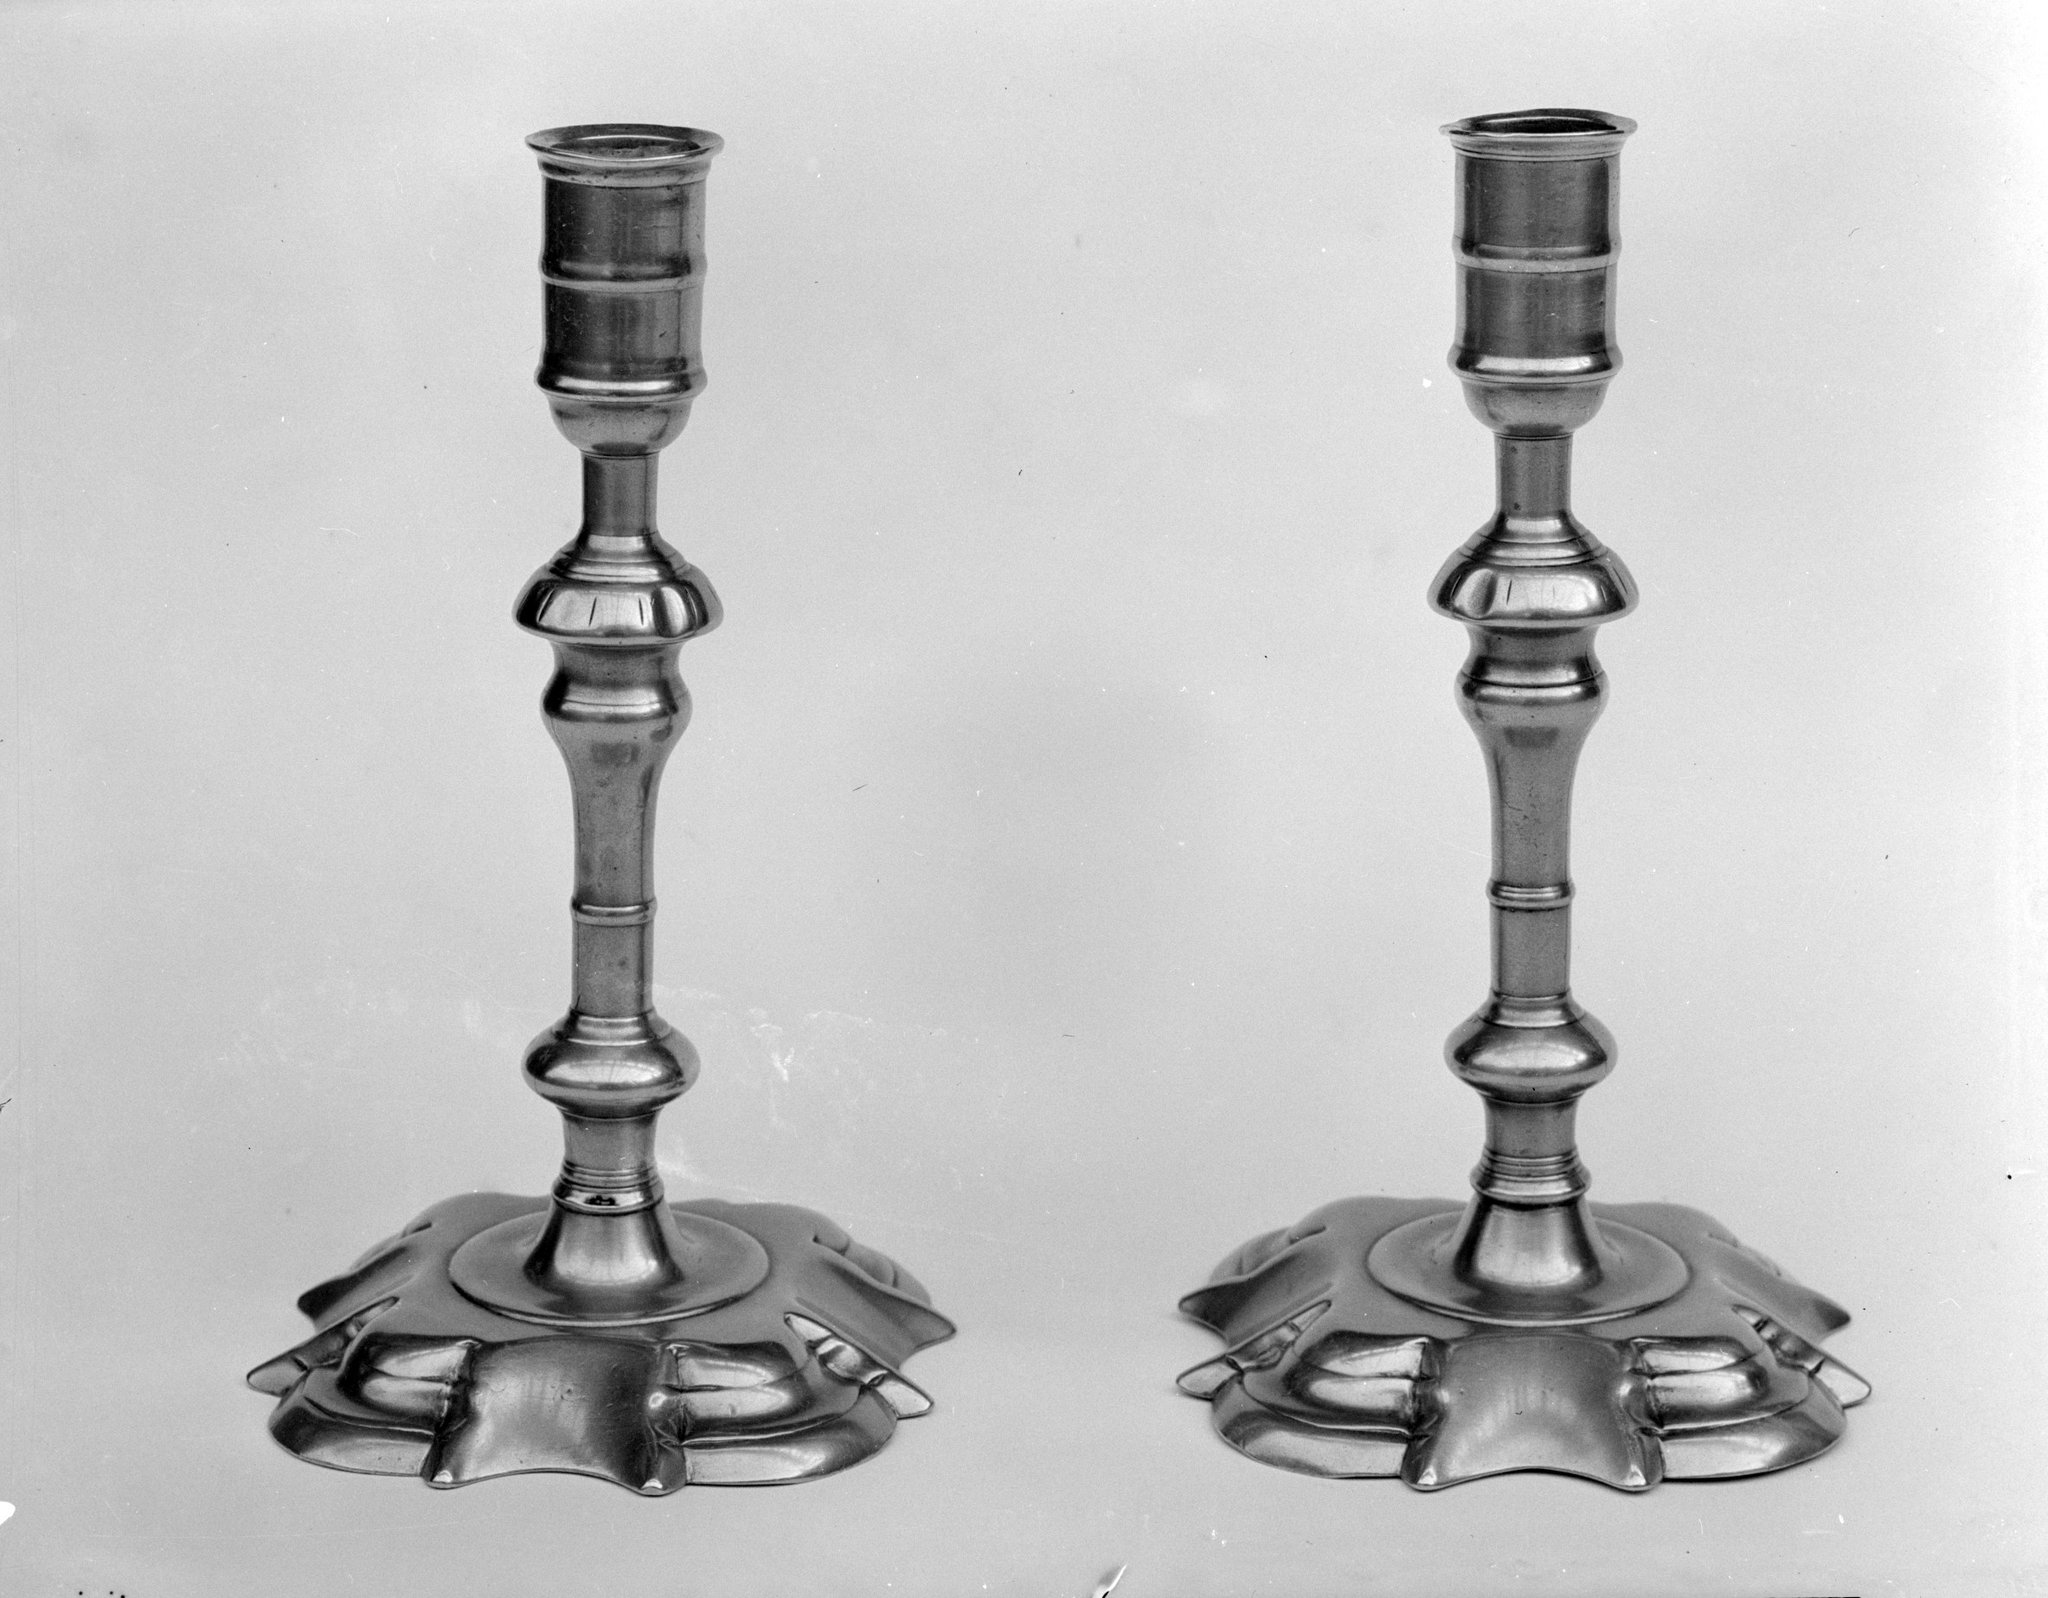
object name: candlestick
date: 1750-1770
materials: brass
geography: england